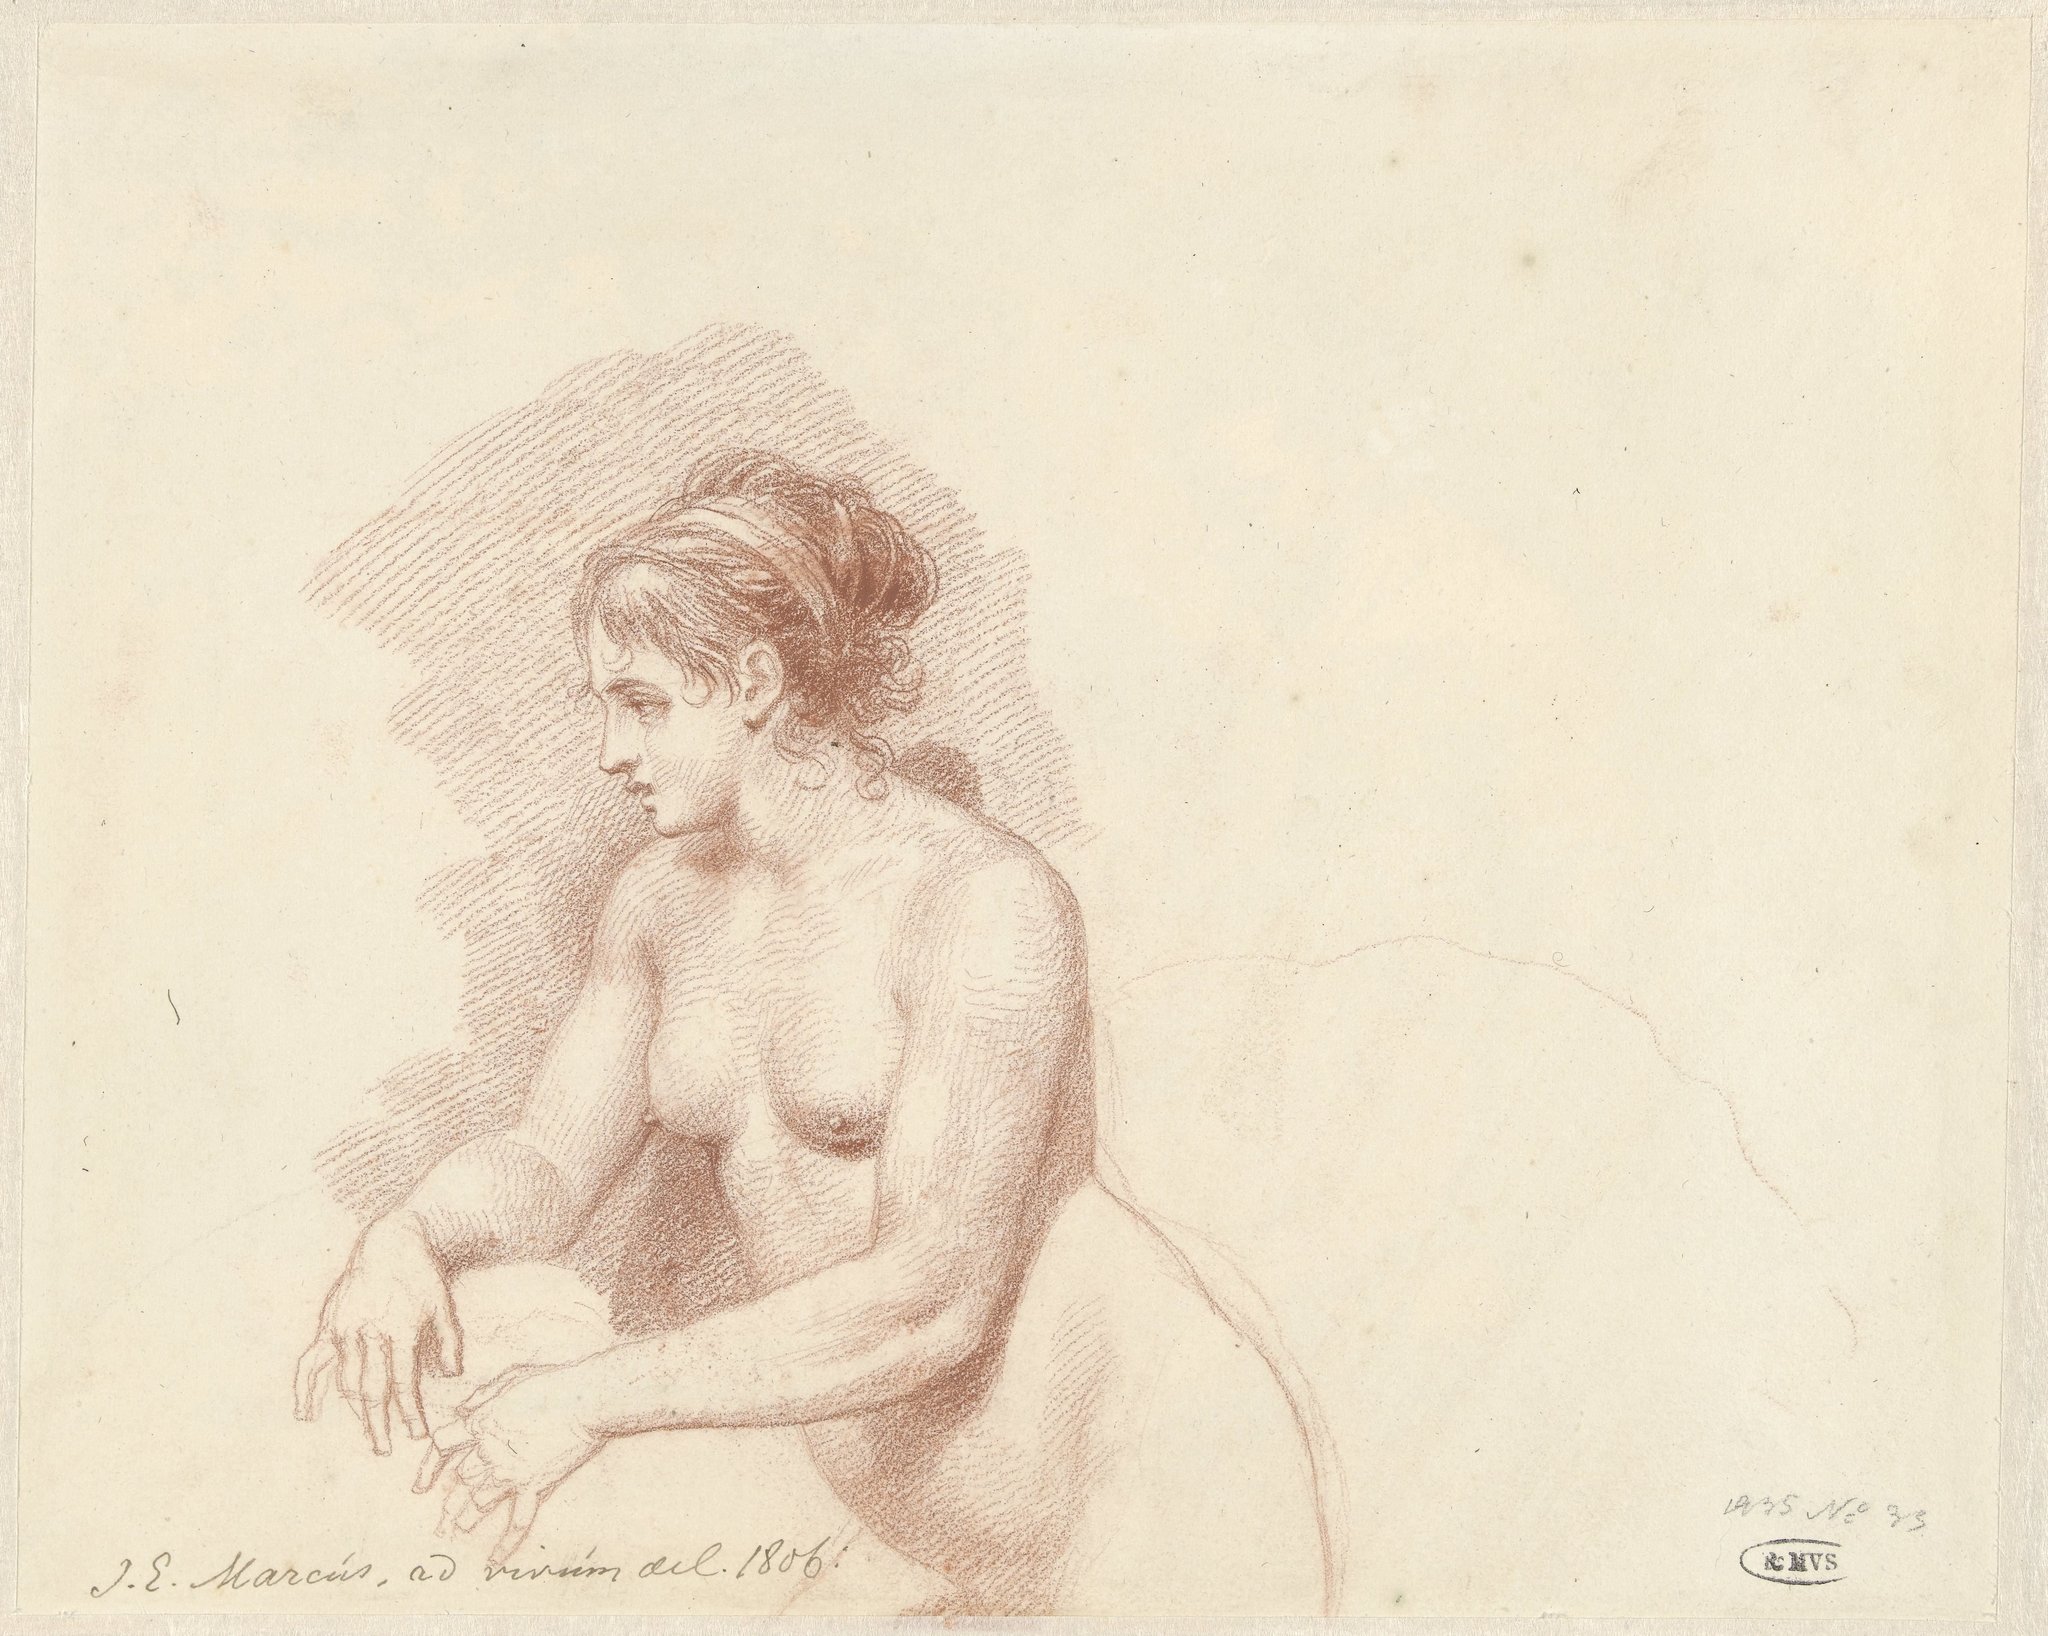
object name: drawing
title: Vrouwelijk naakt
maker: jacob ernst marcus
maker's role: draughtsman, print maker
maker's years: 1774-1826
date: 1806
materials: chalk, paper